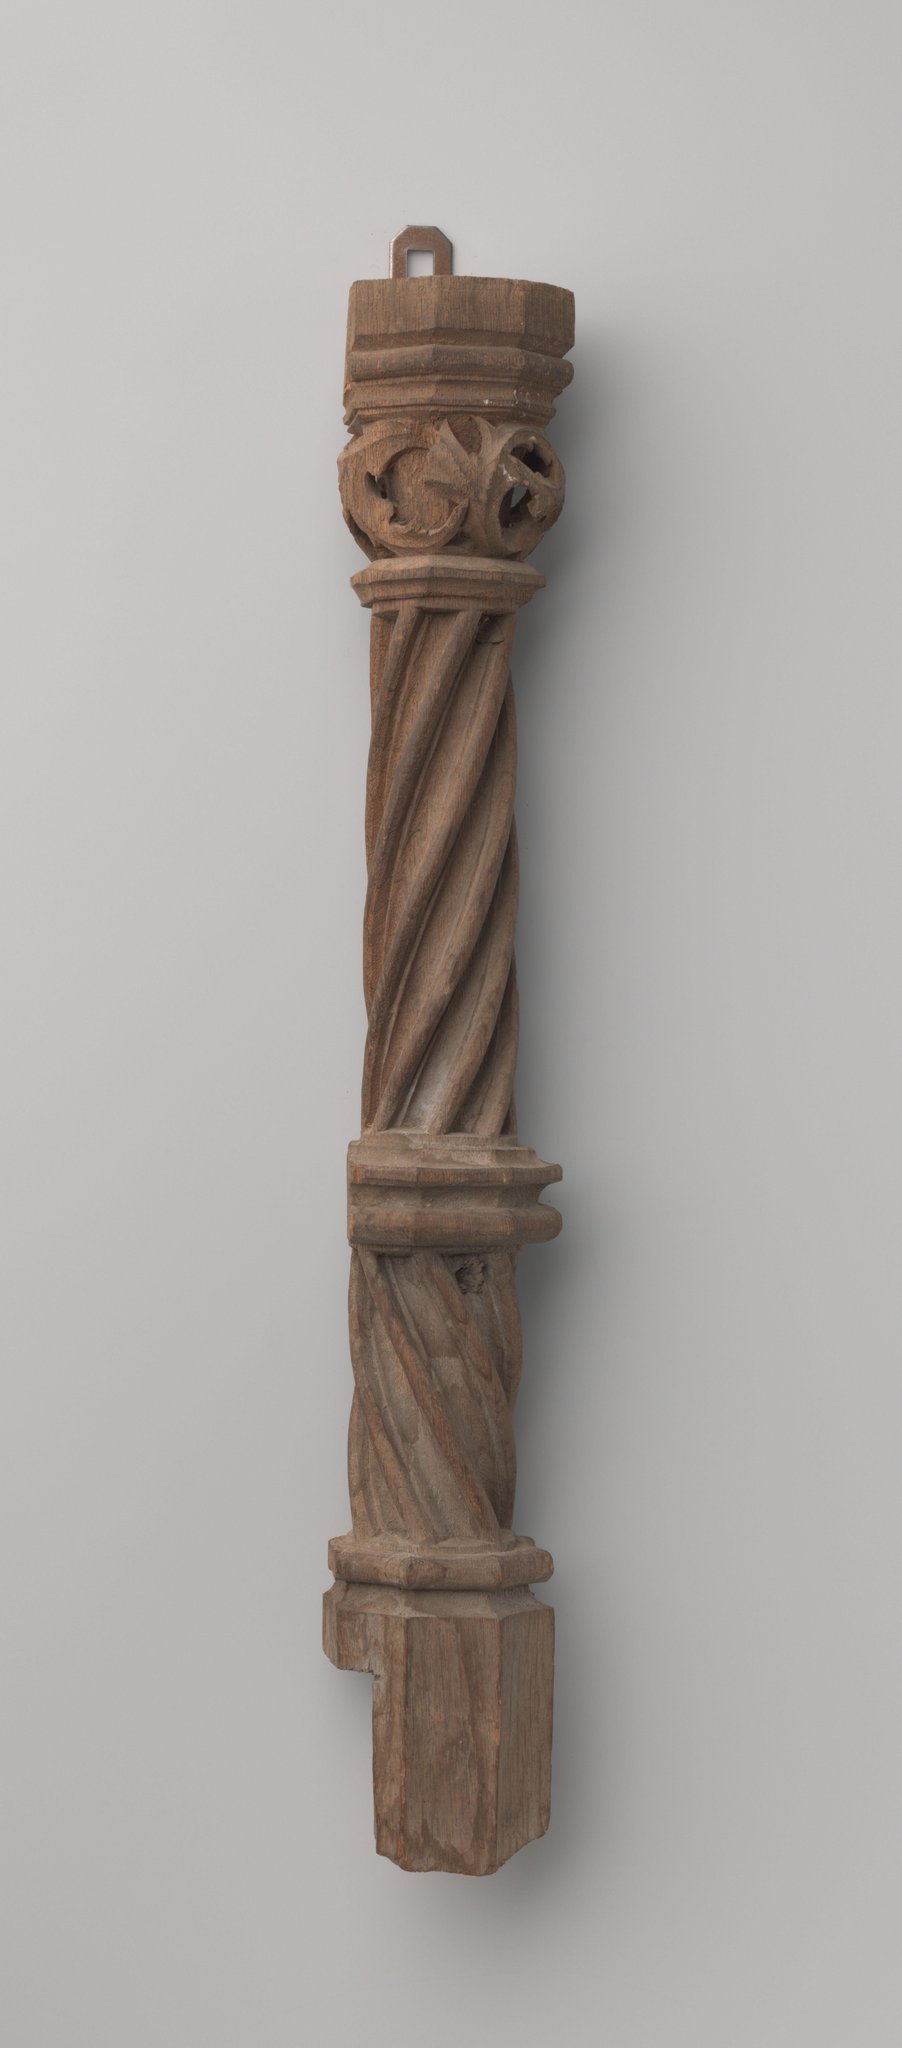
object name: architectural element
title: Colonnet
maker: Anonymous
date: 1400-1950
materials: wood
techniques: gilding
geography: netherlands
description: Colonnet met twee getorneerde delen en snijwerk.